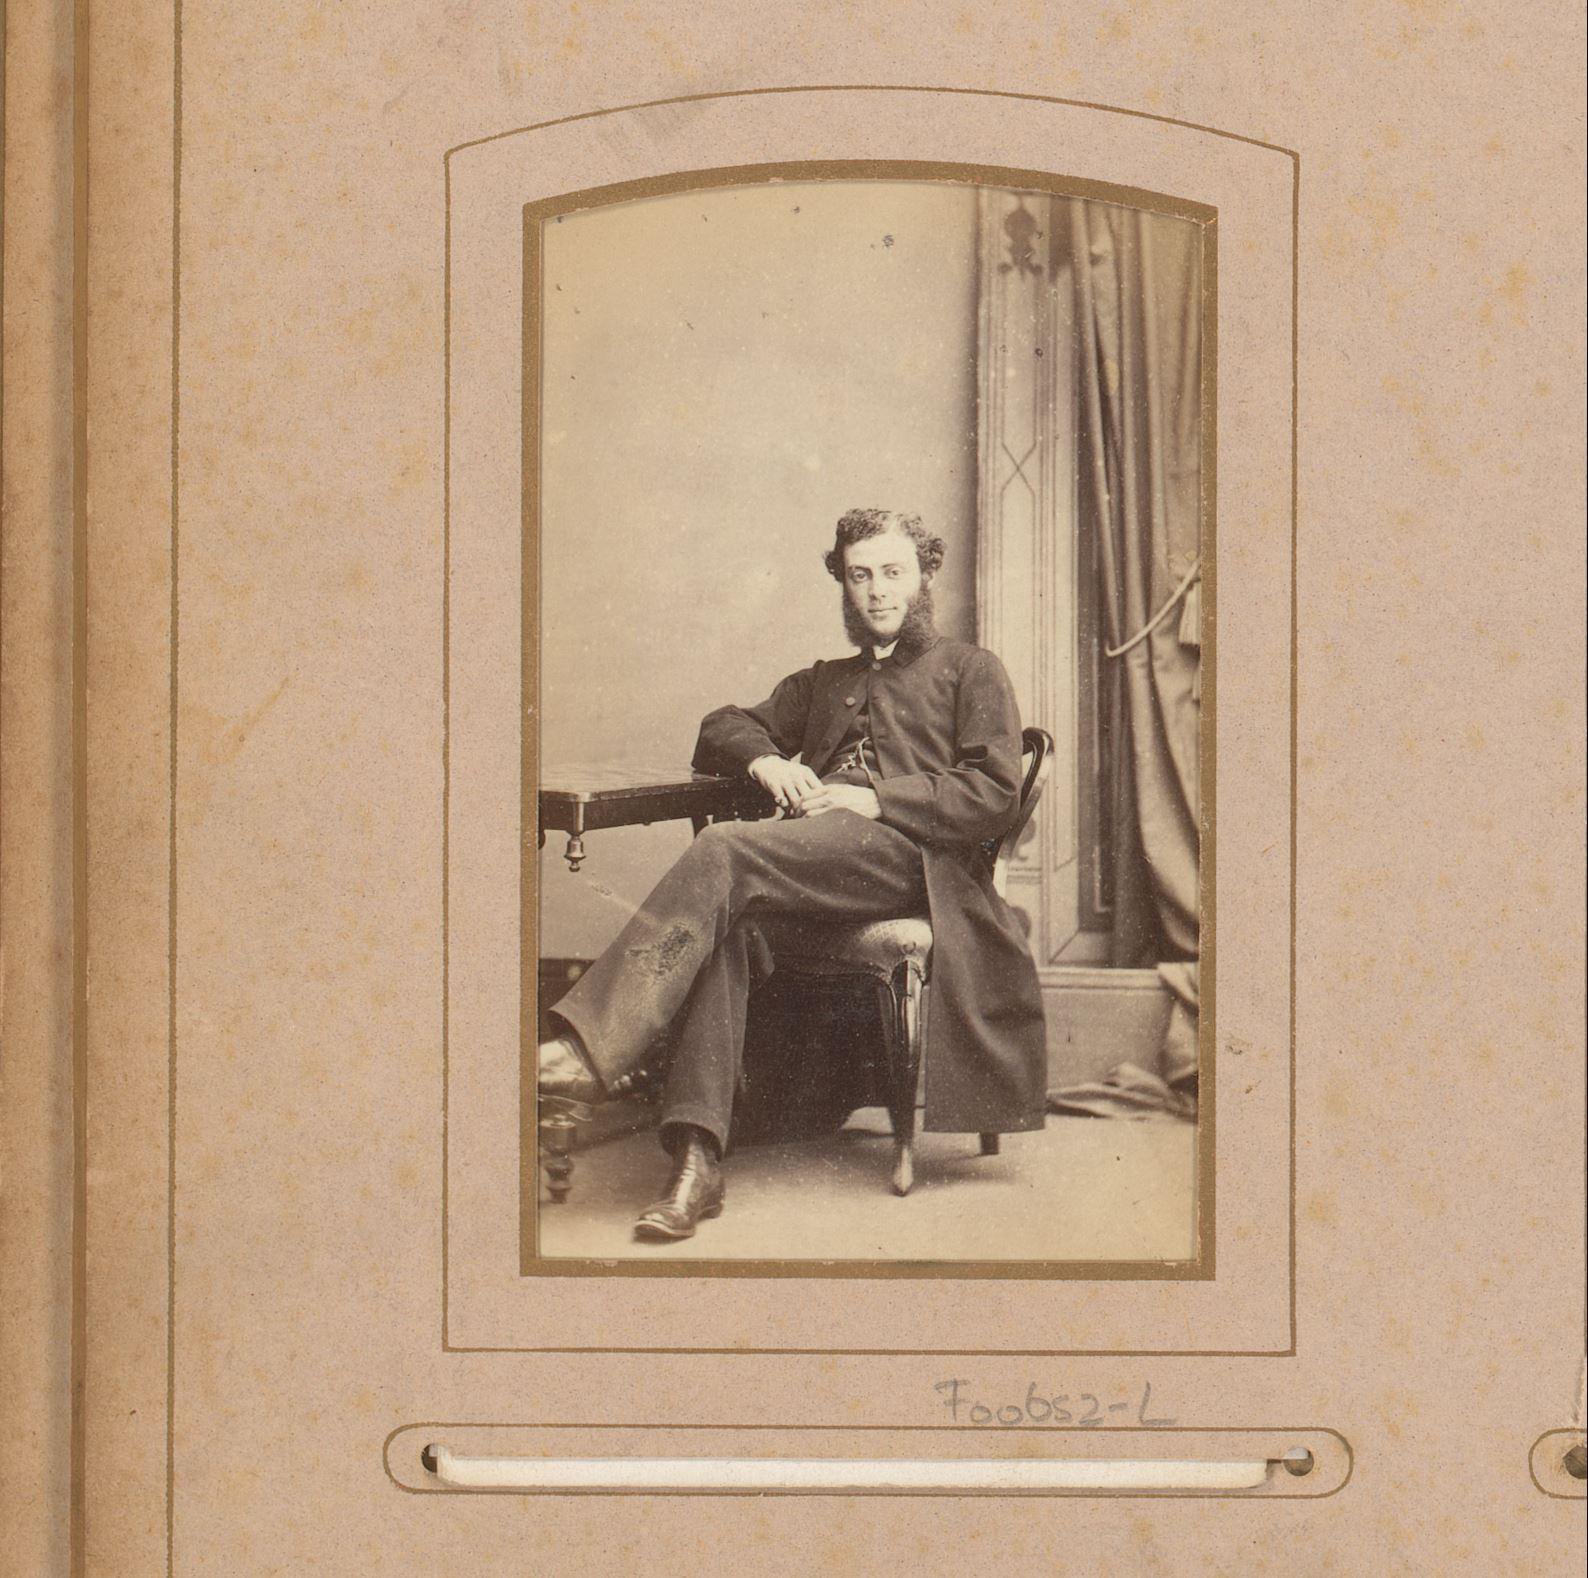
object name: album leaf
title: Portret van een man in lange jas, zittend op een stoel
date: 1870-1890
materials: cardboard, photographic support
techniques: albumen print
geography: norwich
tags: sitting figure, coat, historical persons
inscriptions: inscription: ‘SOLEM CERTISSIMA SIGNA SEQUUNTUR/ Sawyer's Italian Studios/ Norwich/ 46, London St./ Ipswich/ 18, Brook St./ Corner of/ Butter Market/ The No on Registe[r] is 10638A/ Further Copies can always be/ obtained by quoting it.’